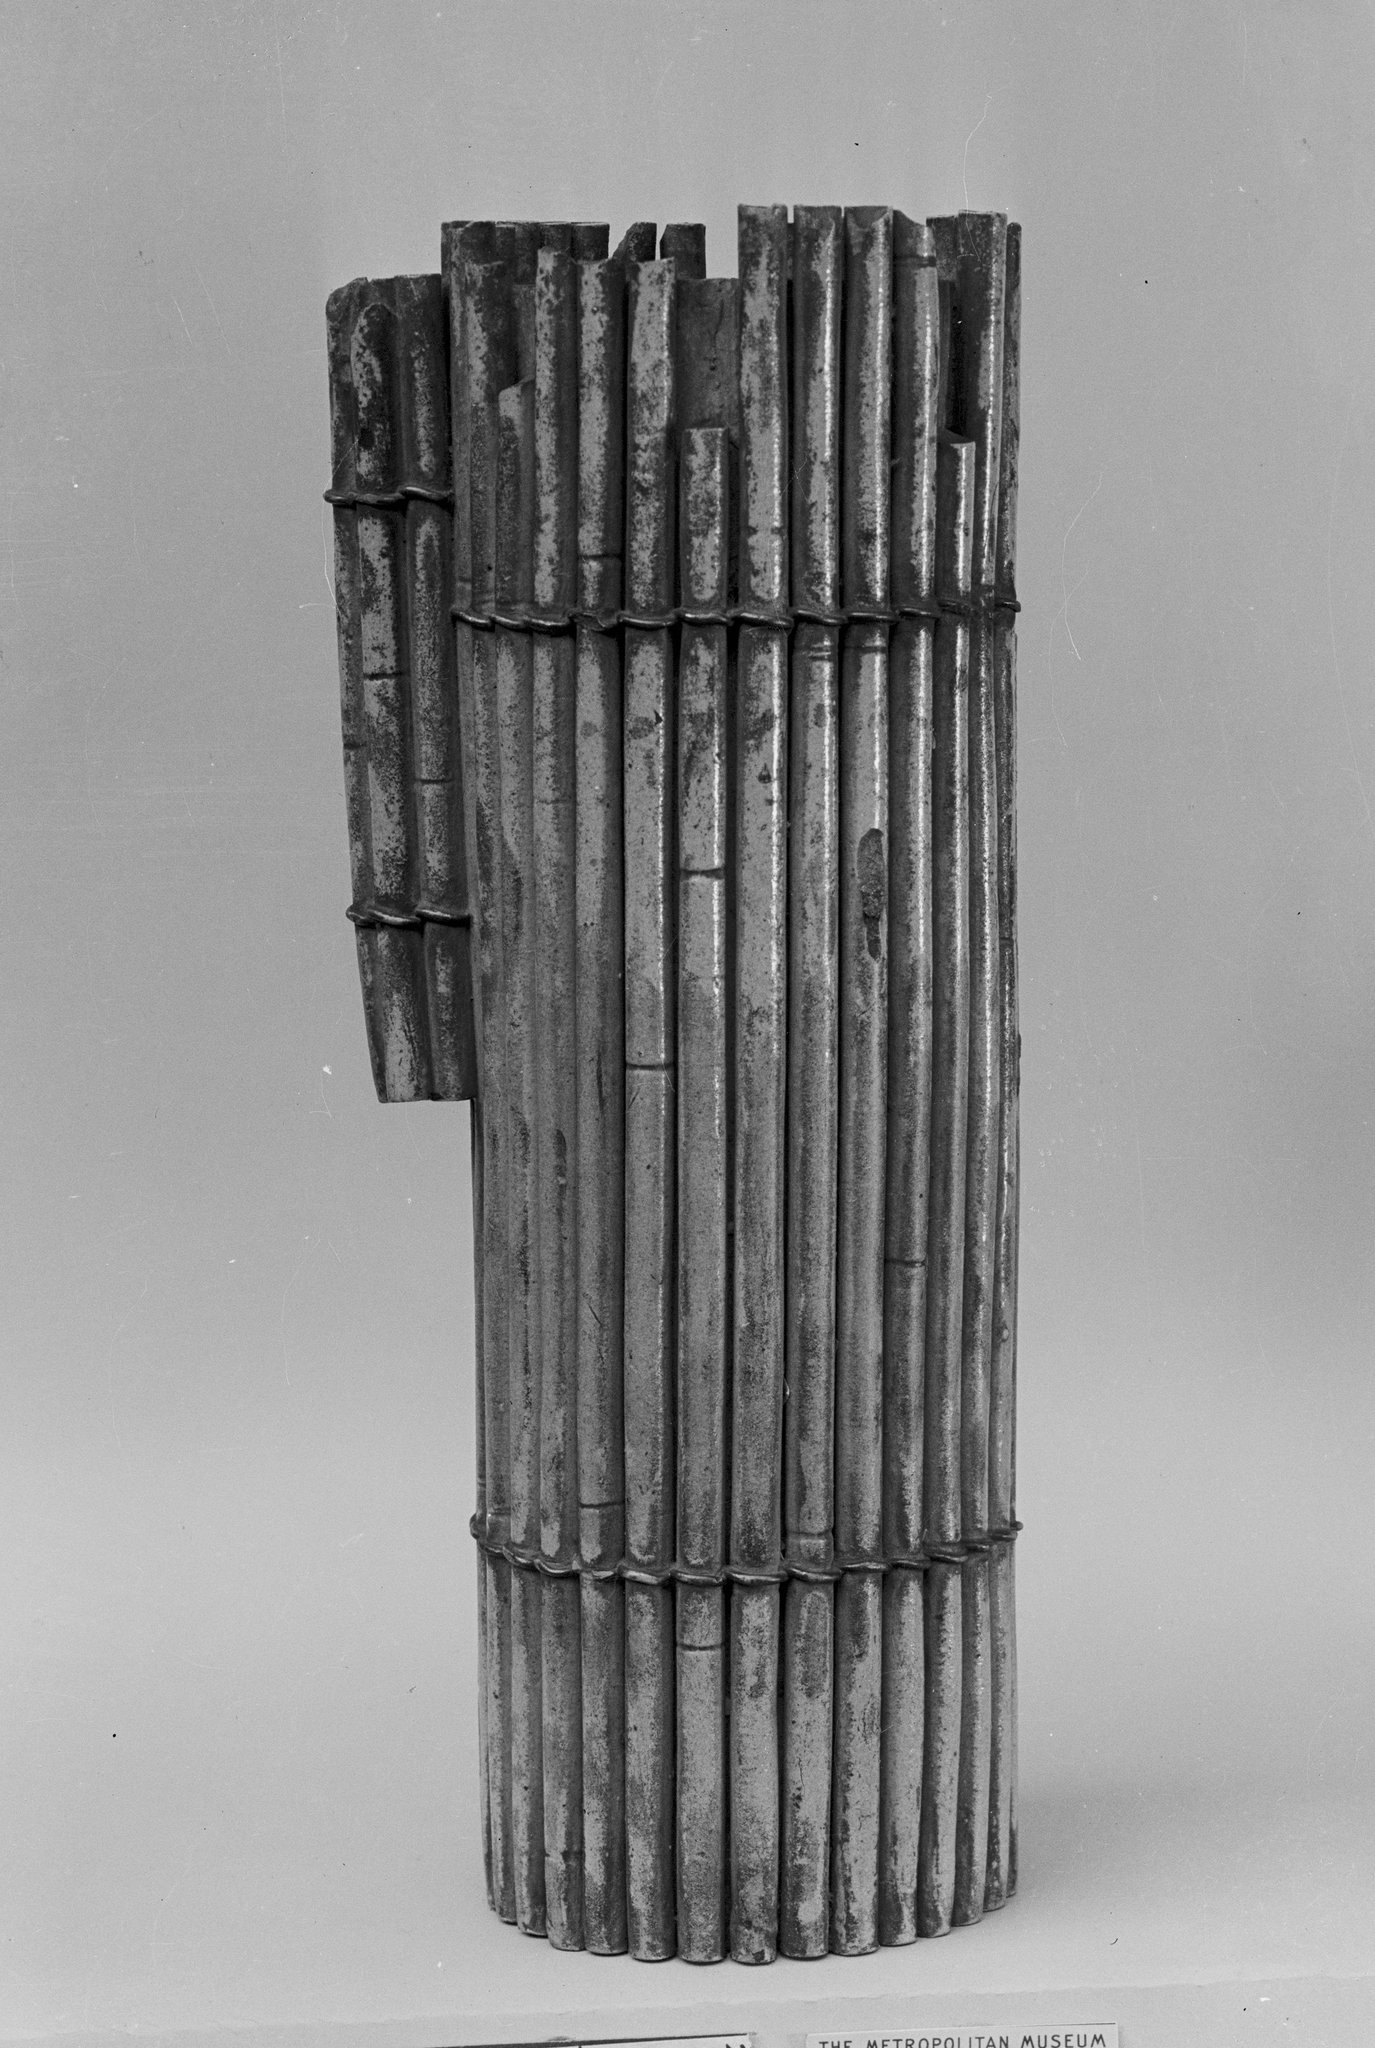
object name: vase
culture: japanese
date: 1700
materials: clay, glaze